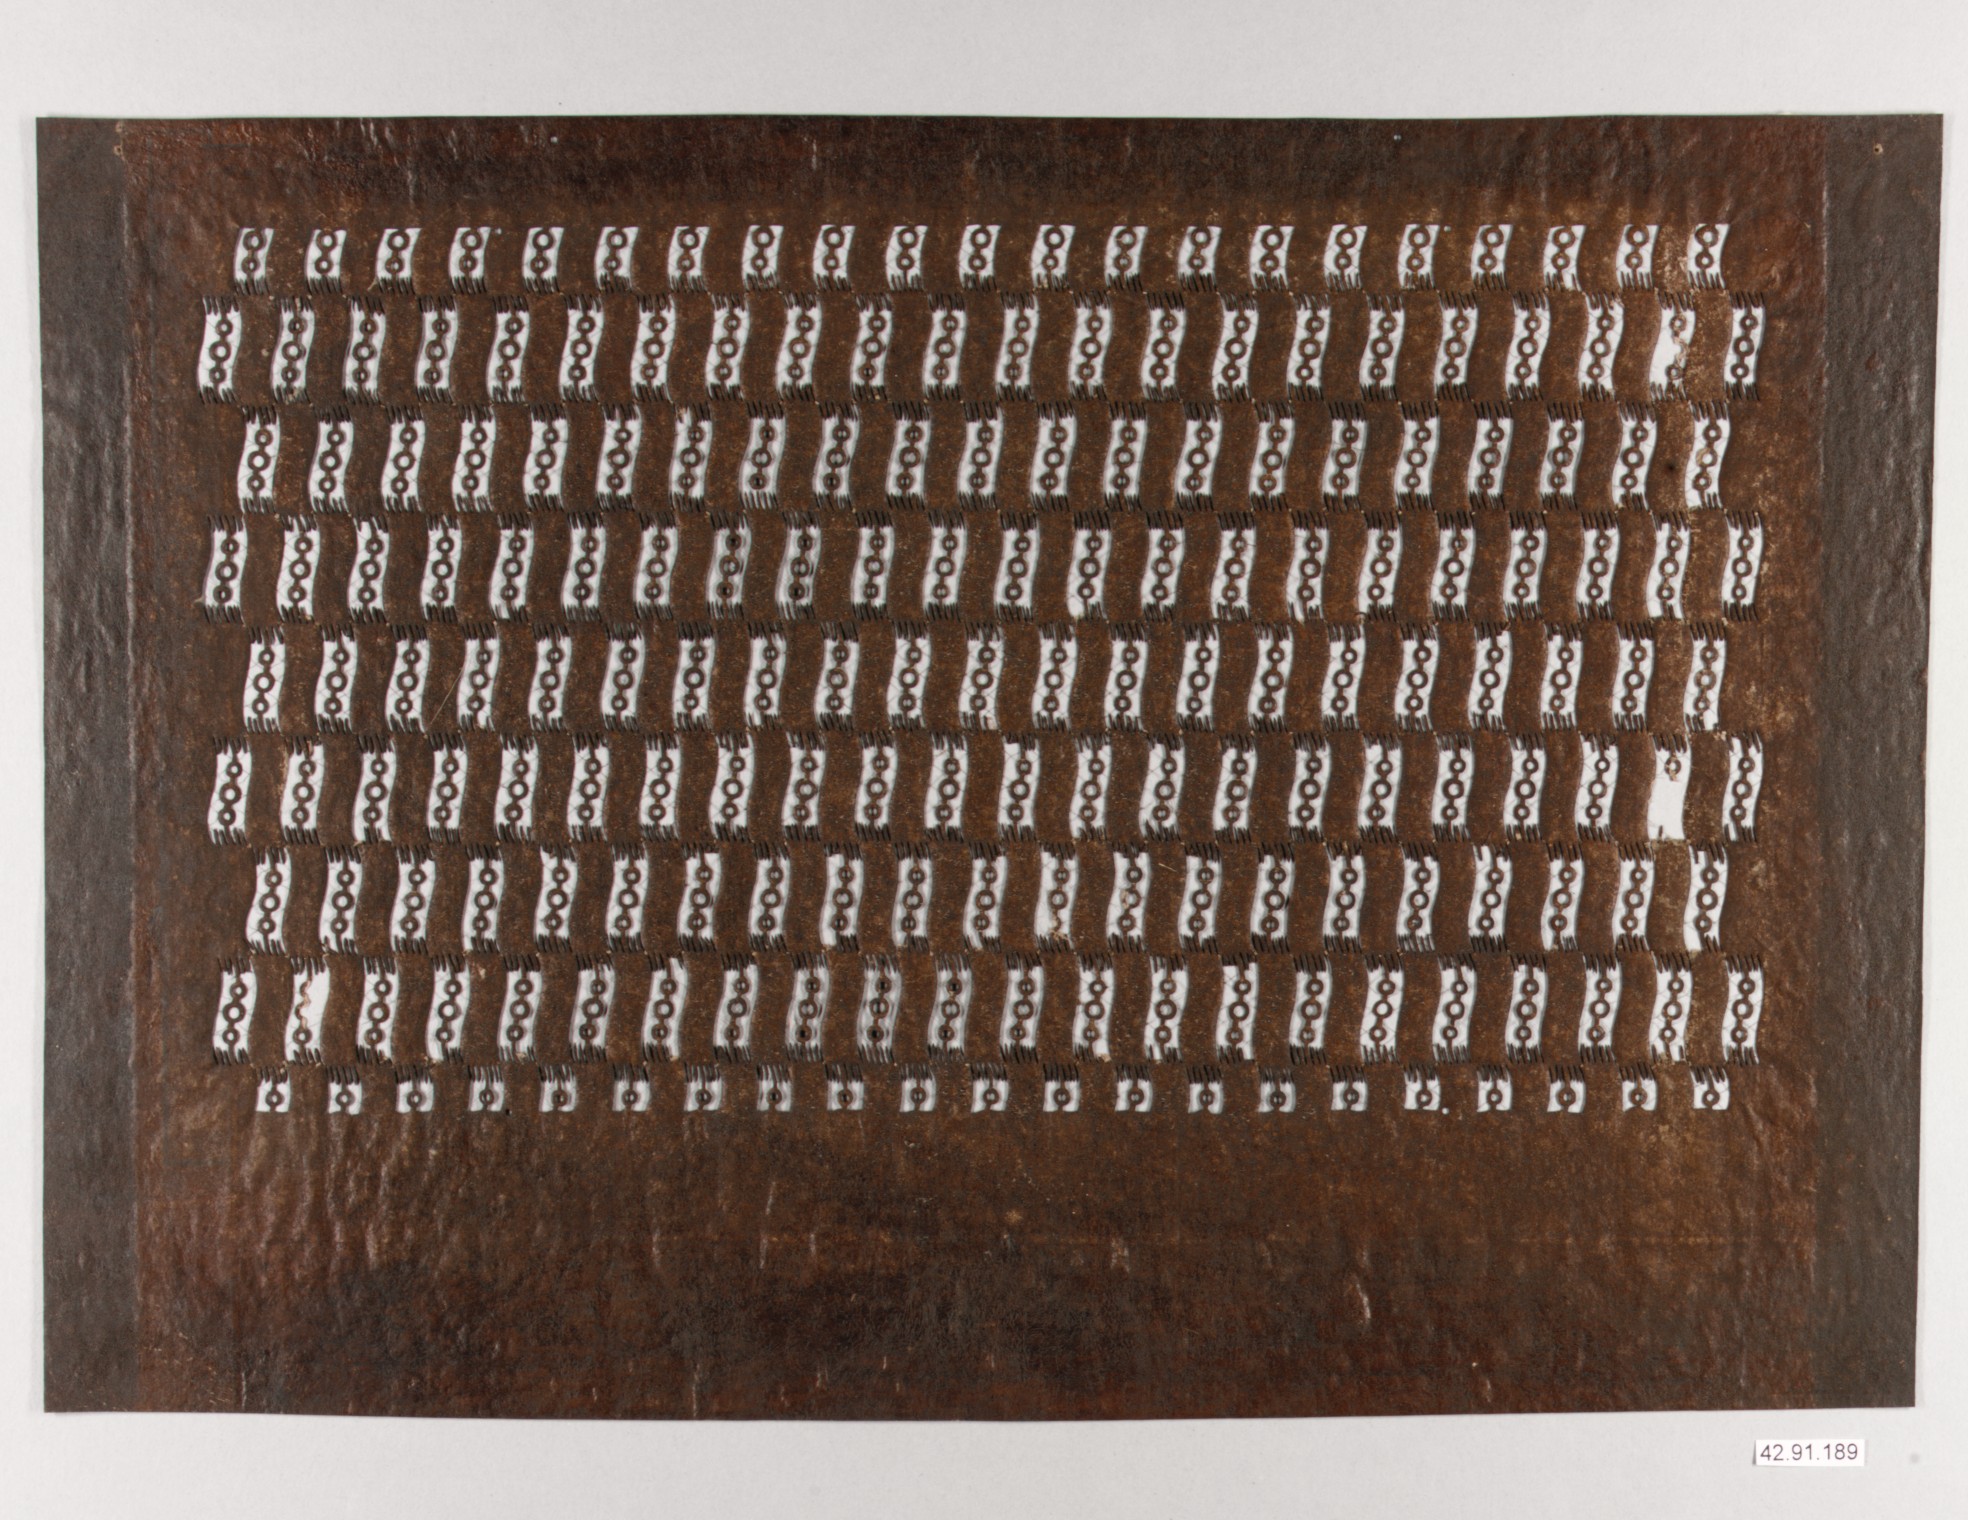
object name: stencil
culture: japanese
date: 1801-1900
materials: paper